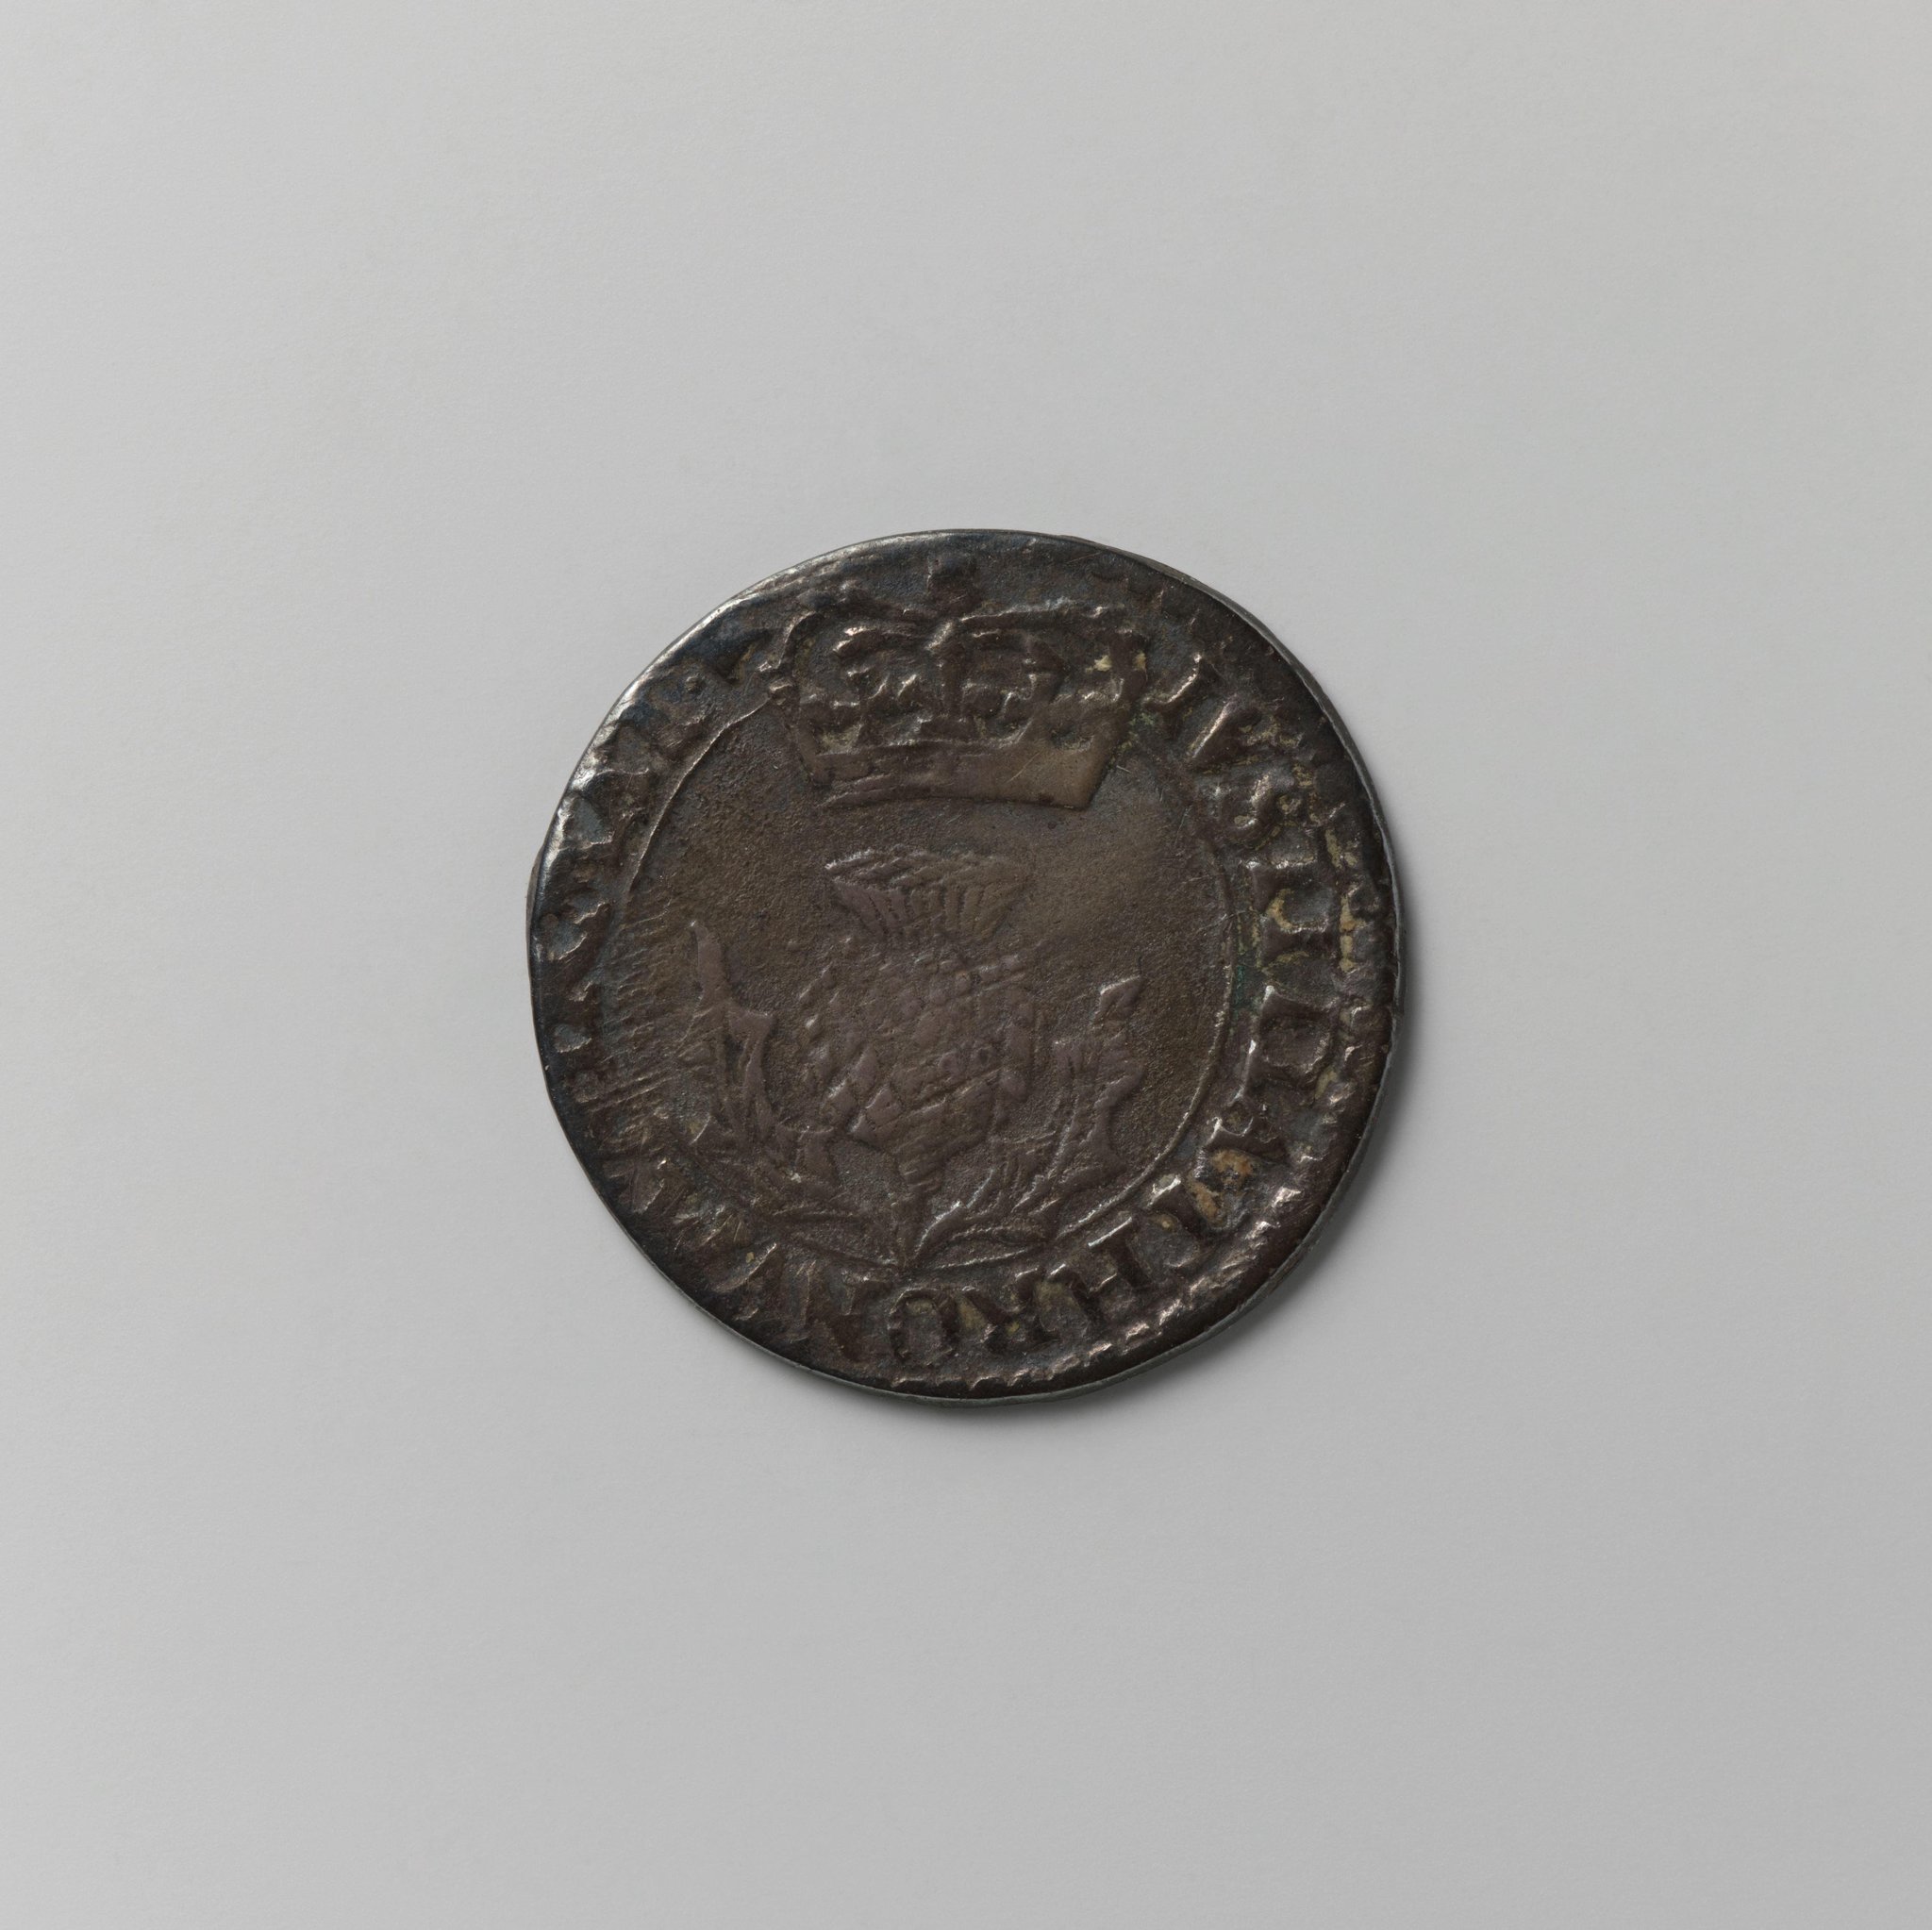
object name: coin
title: 1/4 noble van 20 pence scotch uit Schotland van Karel I, 1625-1648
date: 1625-1648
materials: silver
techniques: striking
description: Zilveren munt. Voorzijde: gekroond borstbeeld naar links. Rechts daarvan waarde-aanduiding XX.. Keerzijde: distel-plant, waarboven kroon